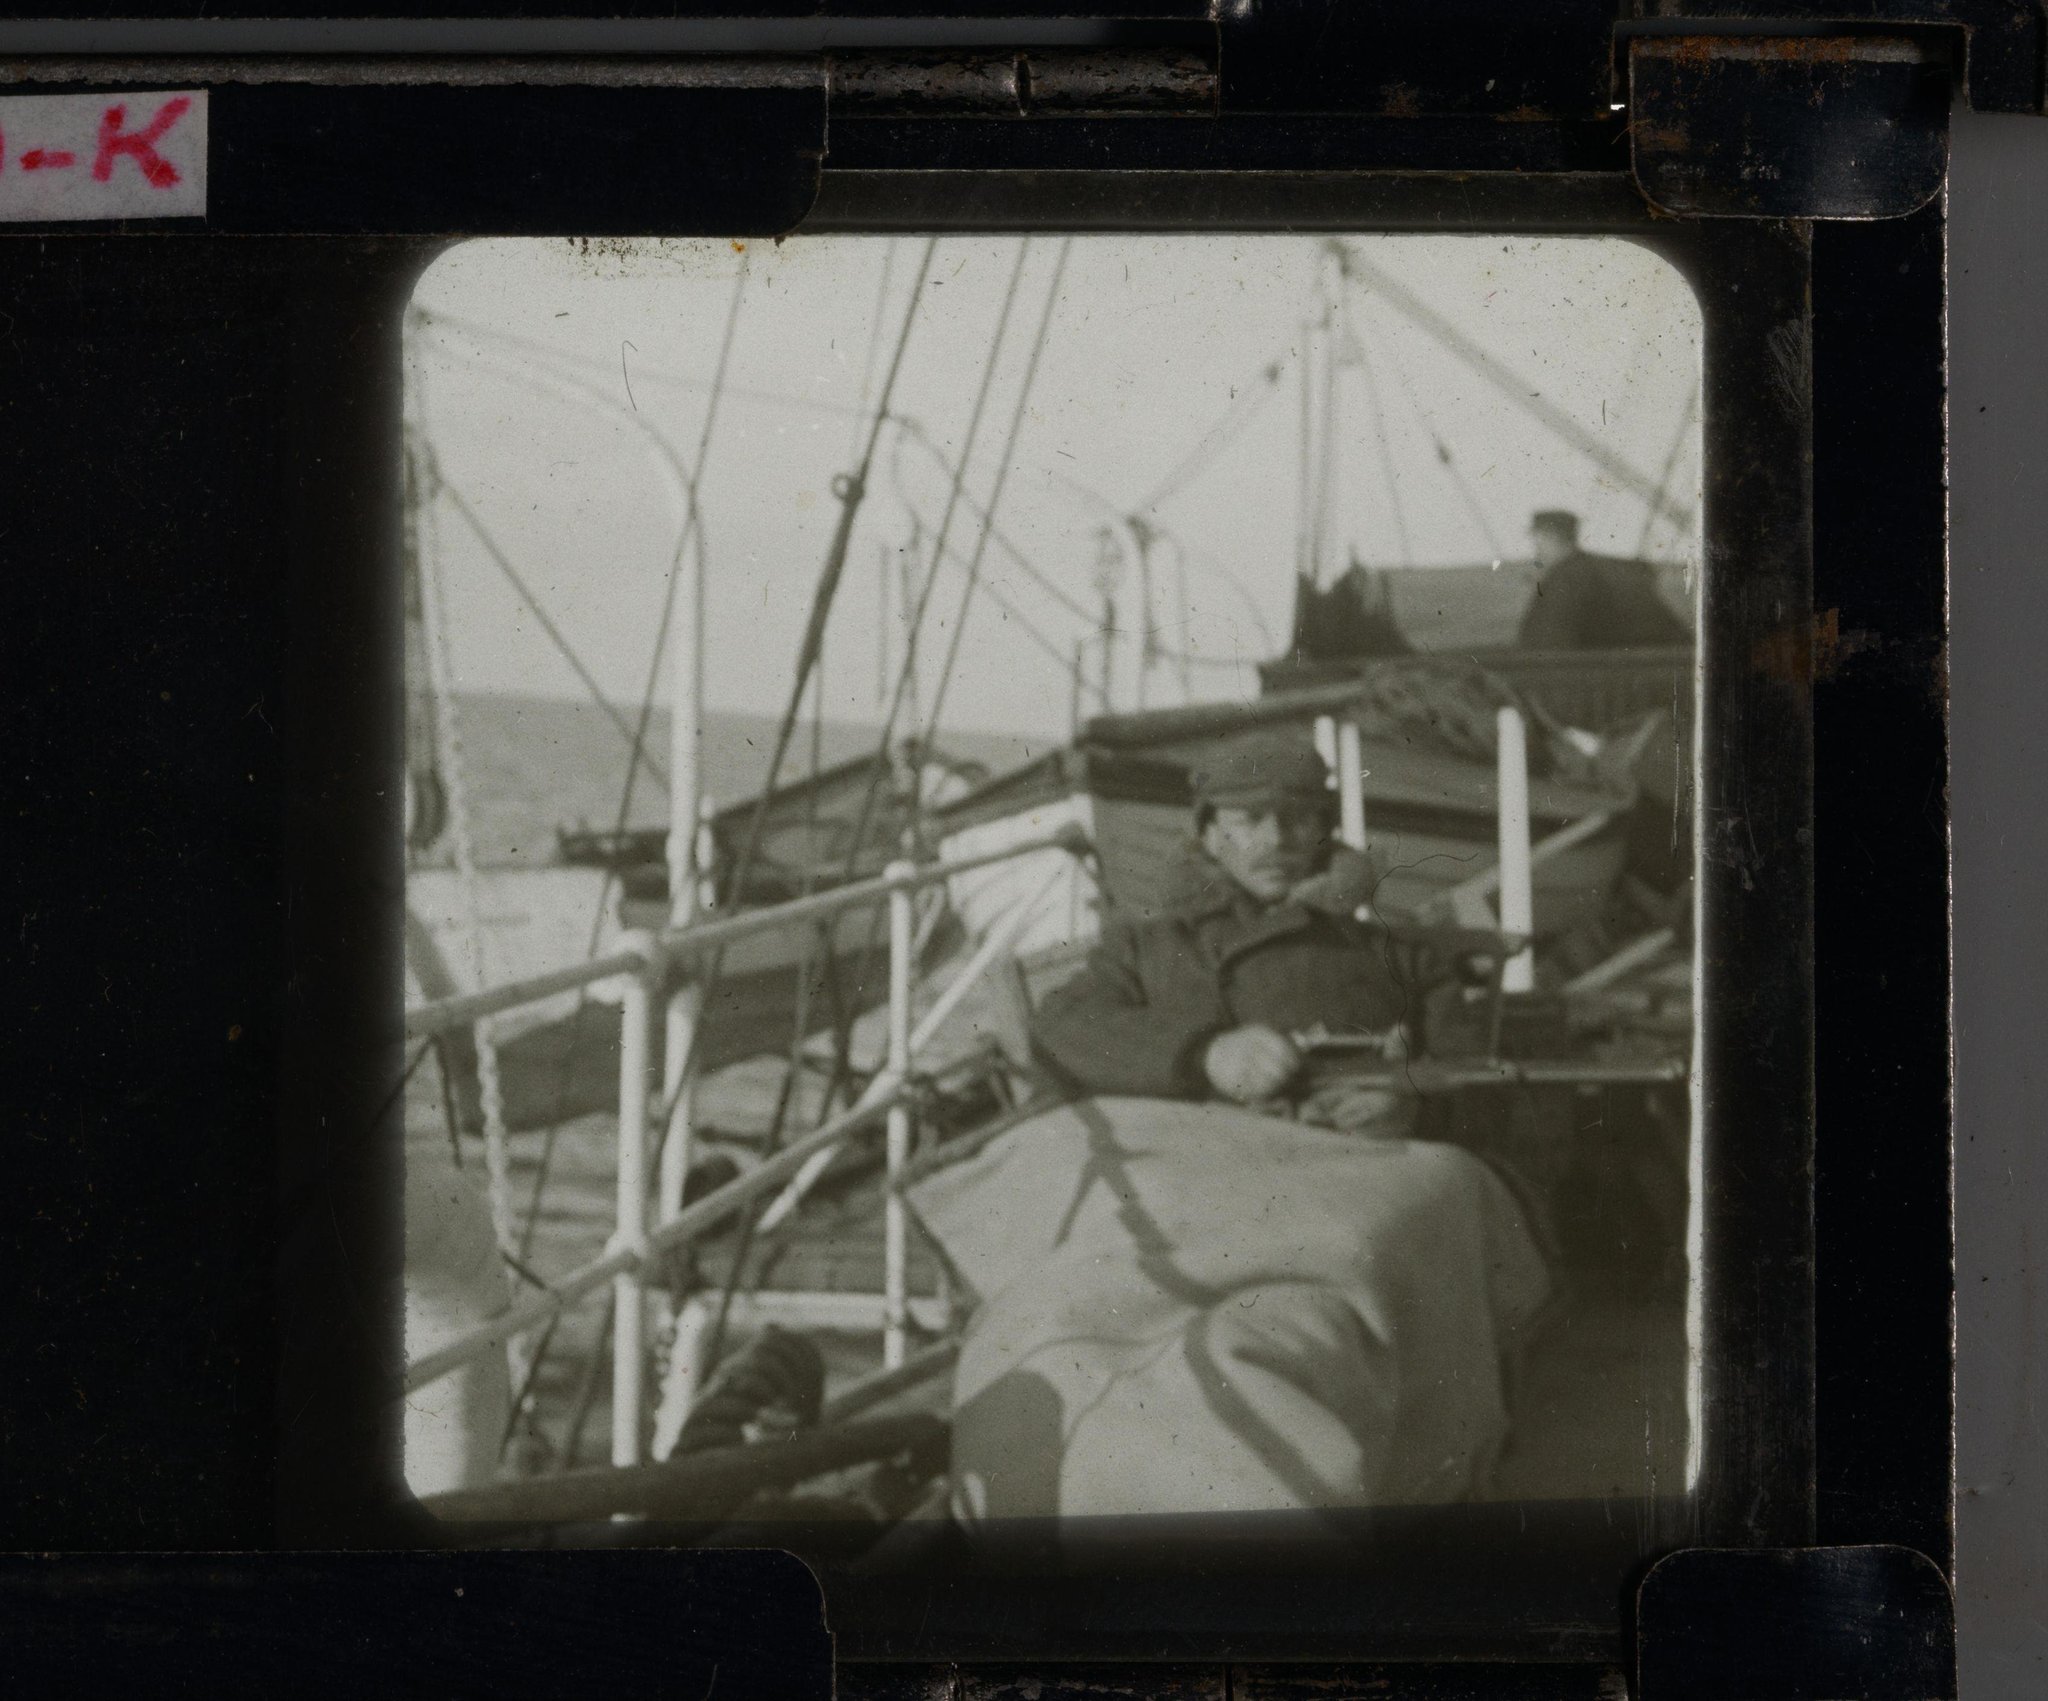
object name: stereoscopic photograph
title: Man liggend onder deken, op het dek van een schip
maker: Anonymous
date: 1893-1923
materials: glass, metal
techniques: slide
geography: paris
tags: crew ~ ship